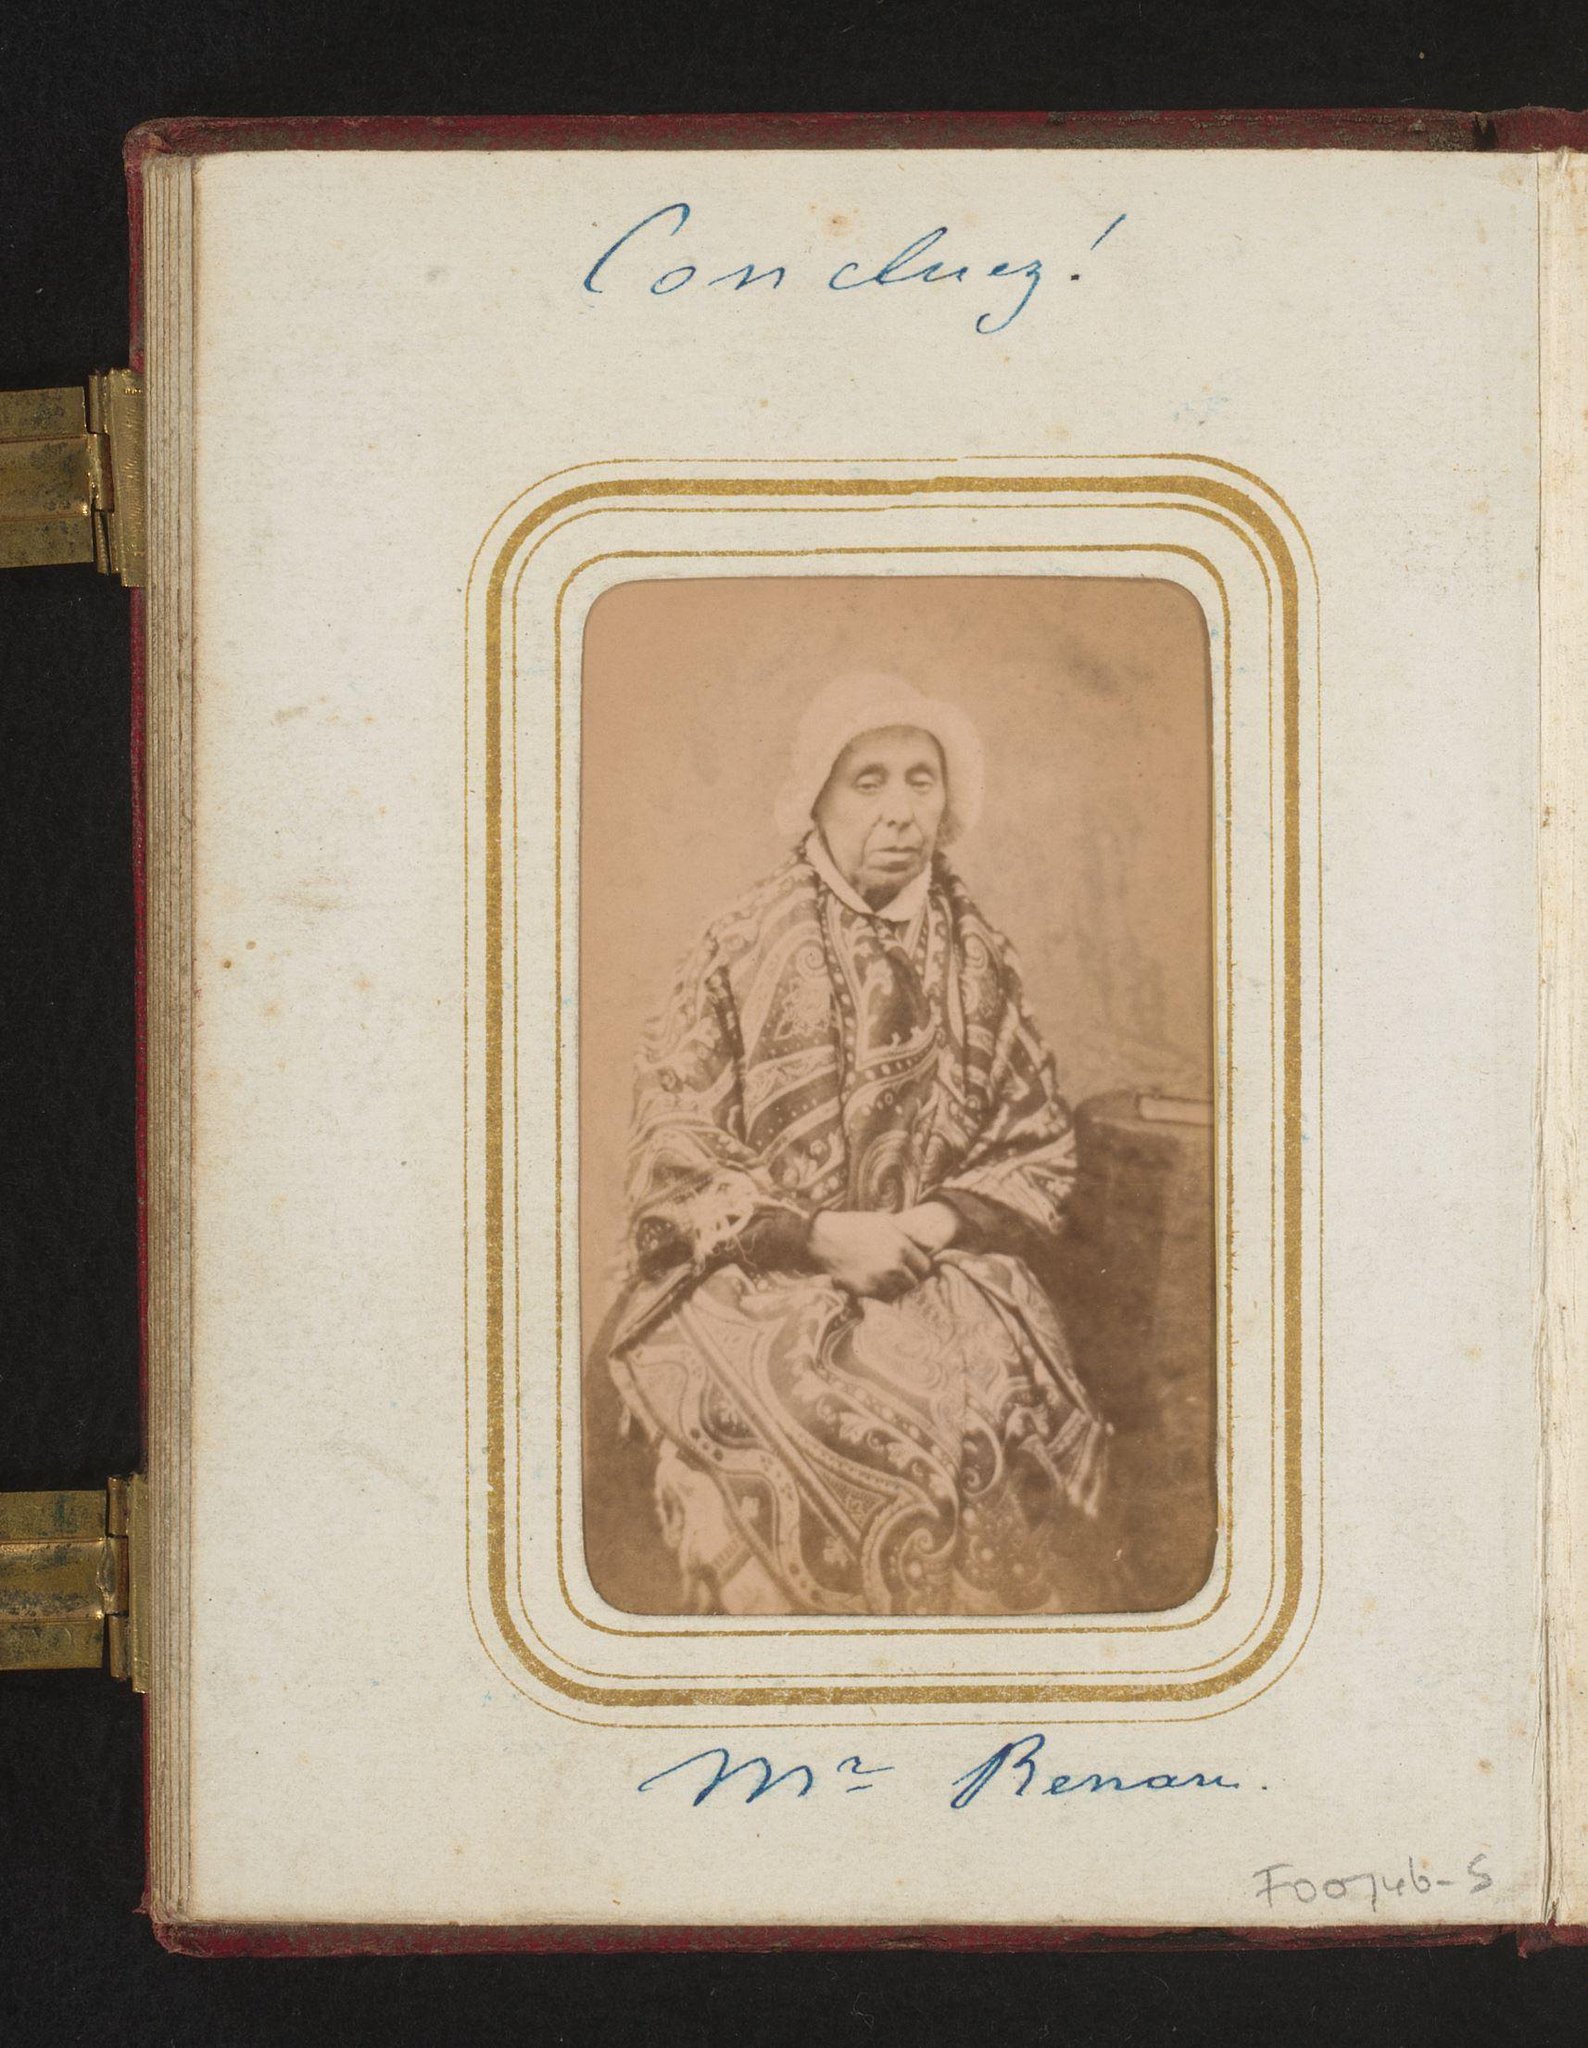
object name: carte de visite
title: Portret van een zittende oudere vrouw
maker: seyve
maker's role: fotograaf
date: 1870-1900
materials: cardboard, photographic support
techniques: albumen print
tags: adult woman, historical persons, head-gear: cap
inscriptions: annotation: ‘concluez!/ Me. Benan’